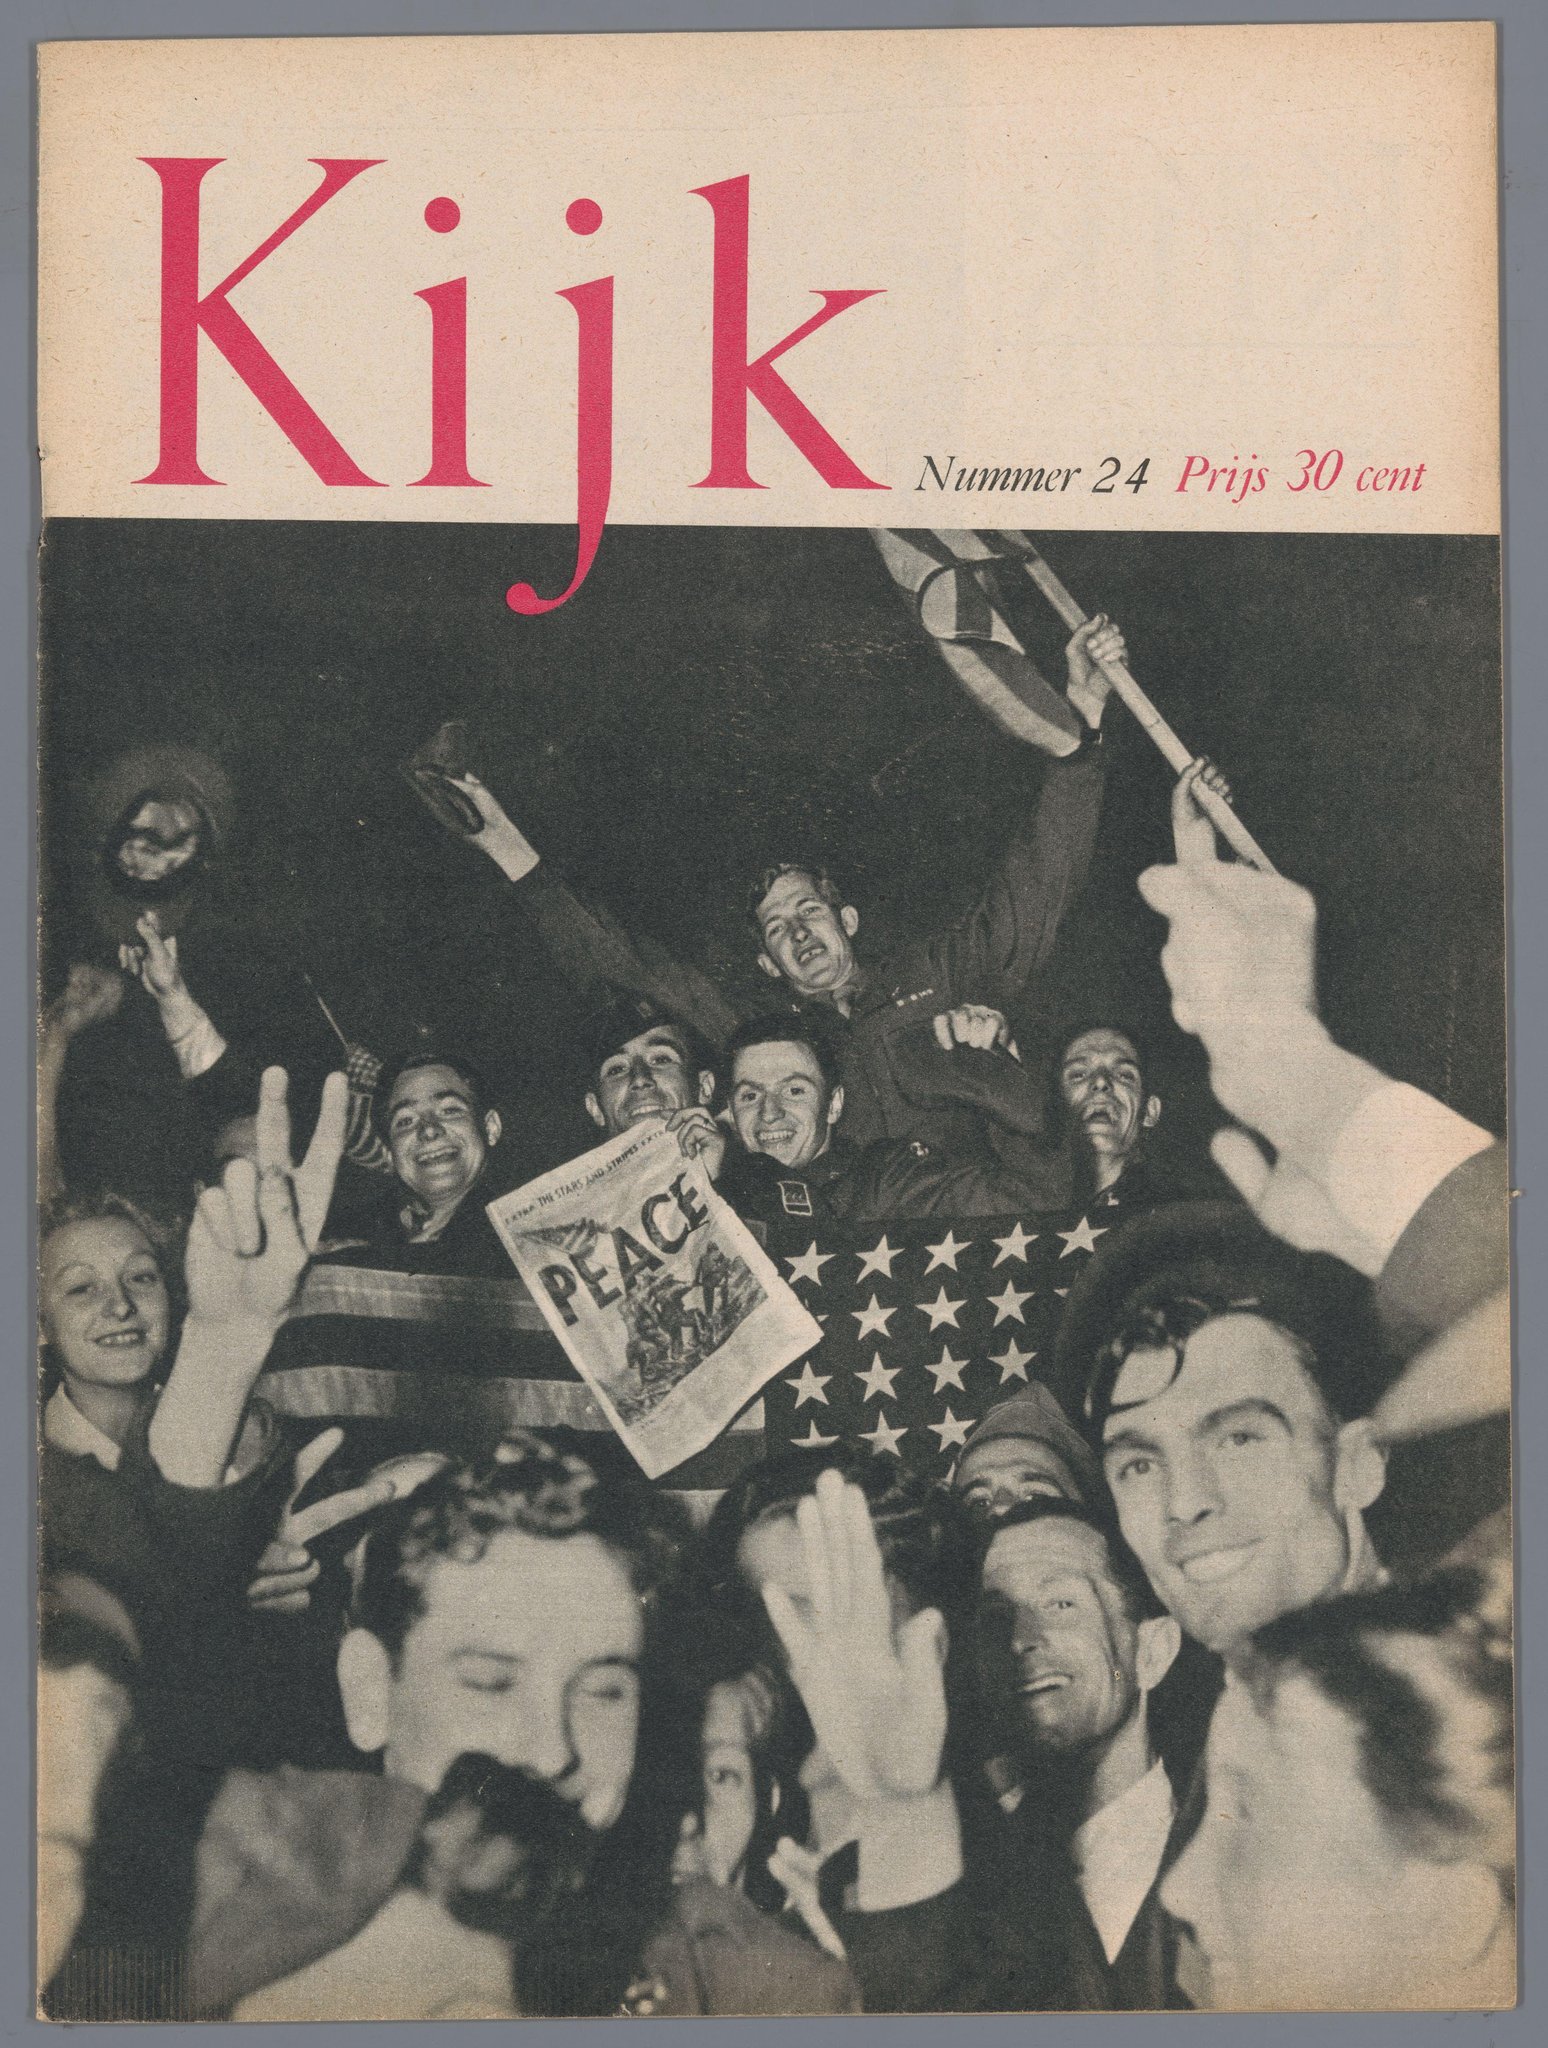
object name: magazine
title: 'Kijk', exemplaar nr. 24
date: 1945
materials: paper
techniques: printing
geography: london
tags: tweede wereldoorlog, bevrijding van nederland (1945)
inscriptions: title: ‘Kijk’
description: "Kijk wordt om de veertien dagen uitgegeven door de Amerikaanschen Voorlichingsdienst om eht wereldnieuws te geven in woord en beeld, totdat uw eigen pers deze taak kan overnemen." Omschrijving van het blad Kijk, overgenomen uit dit blad.